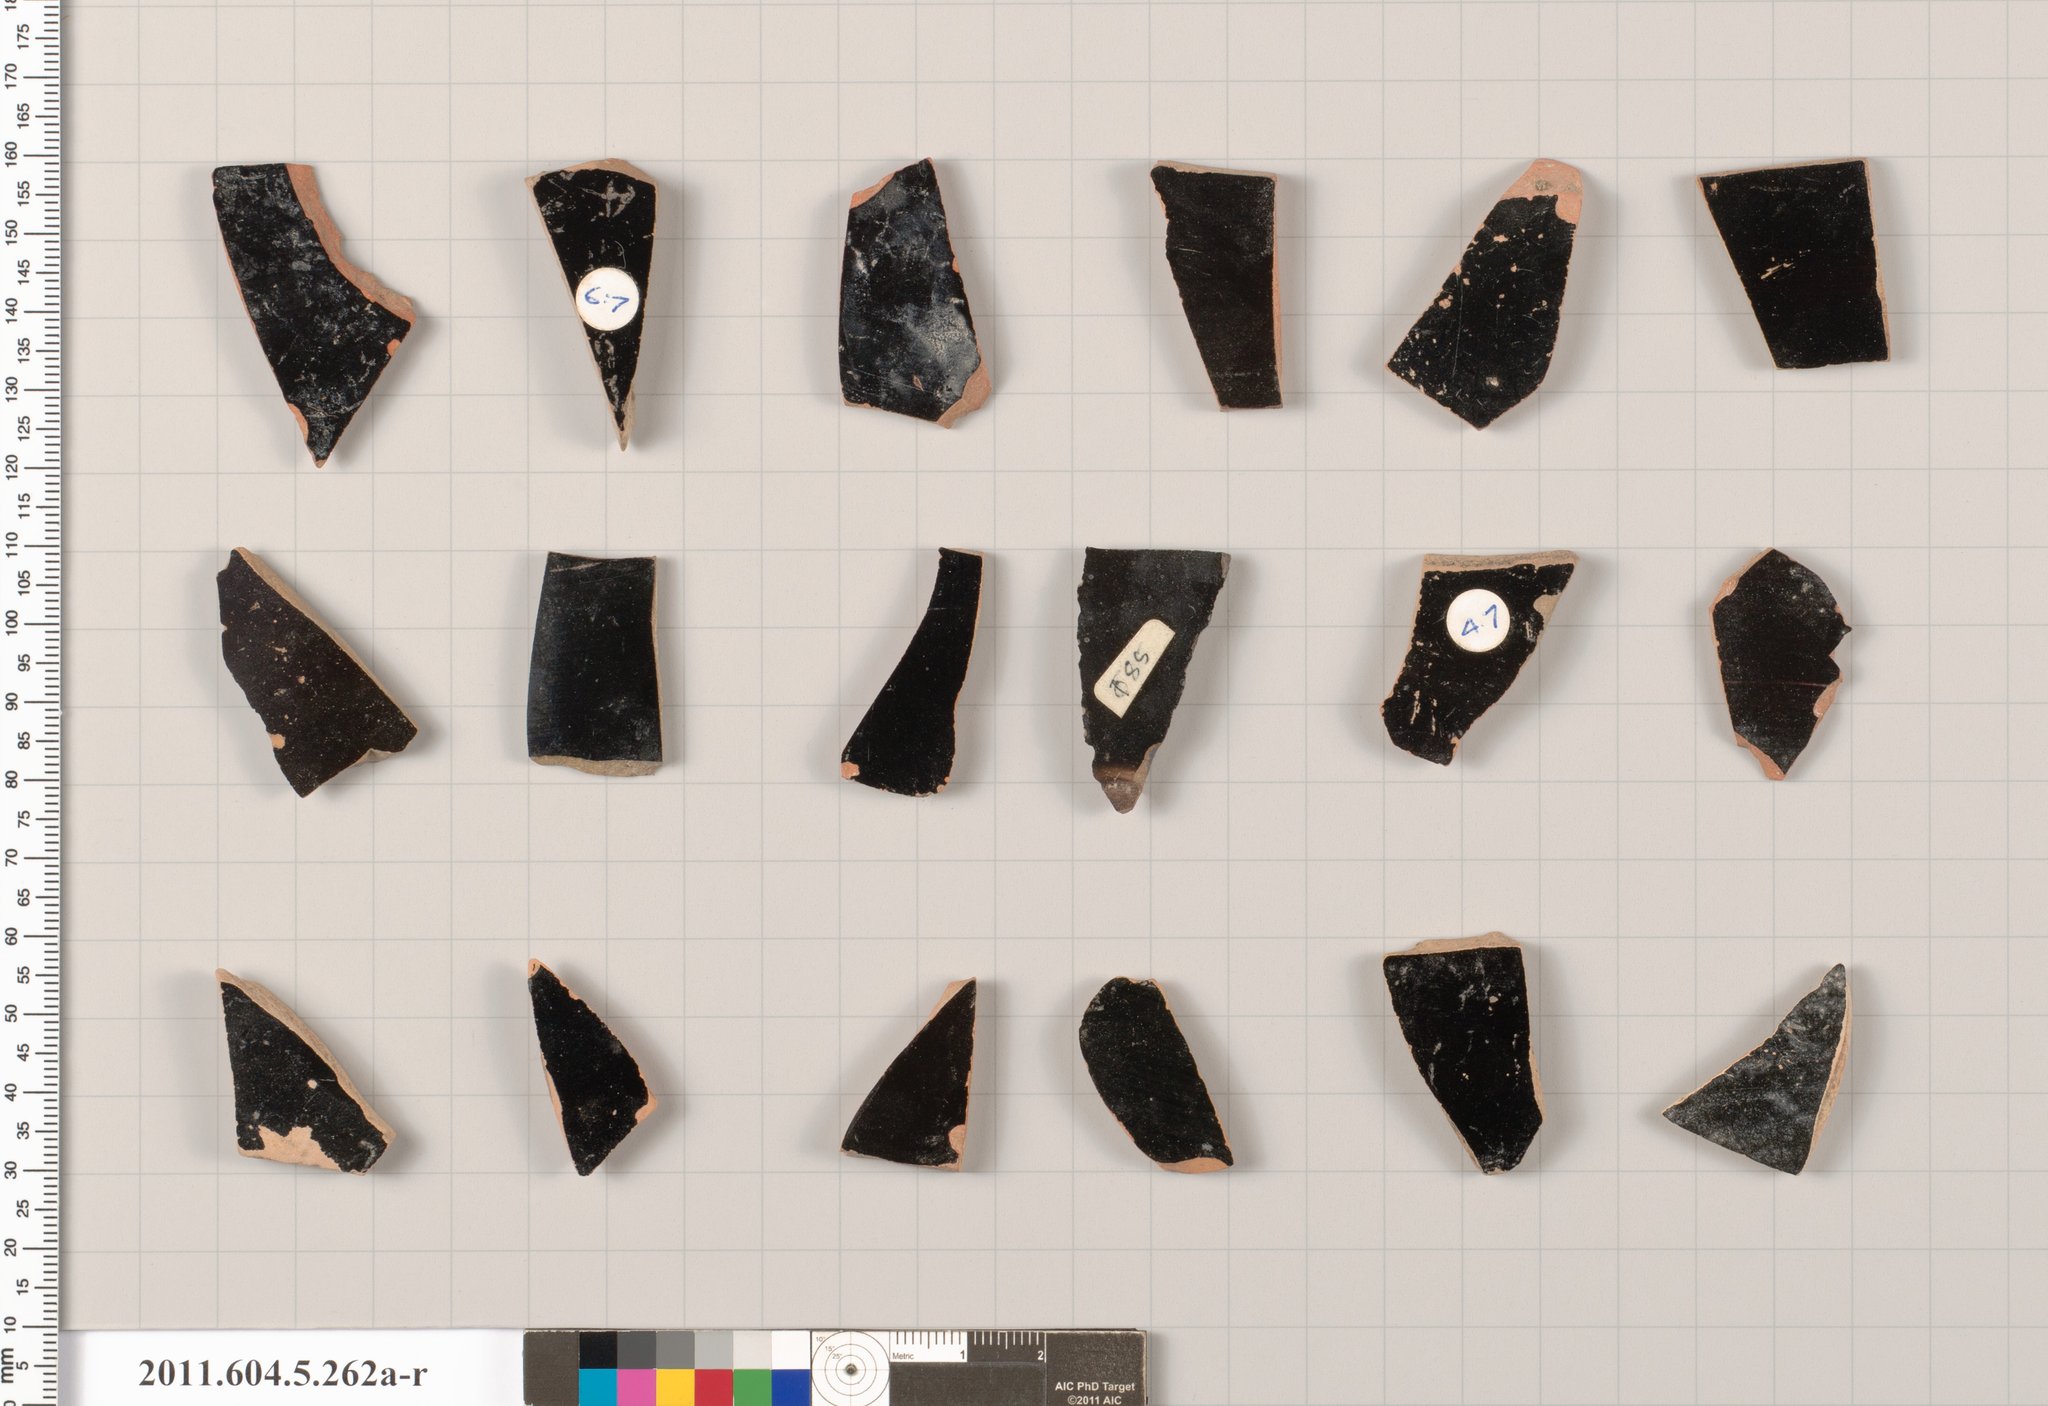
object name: kylix fragment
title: Terracotta fragments of kylikes (drinking cups)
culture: greek, attic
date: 600-401 BCE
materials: terracotta